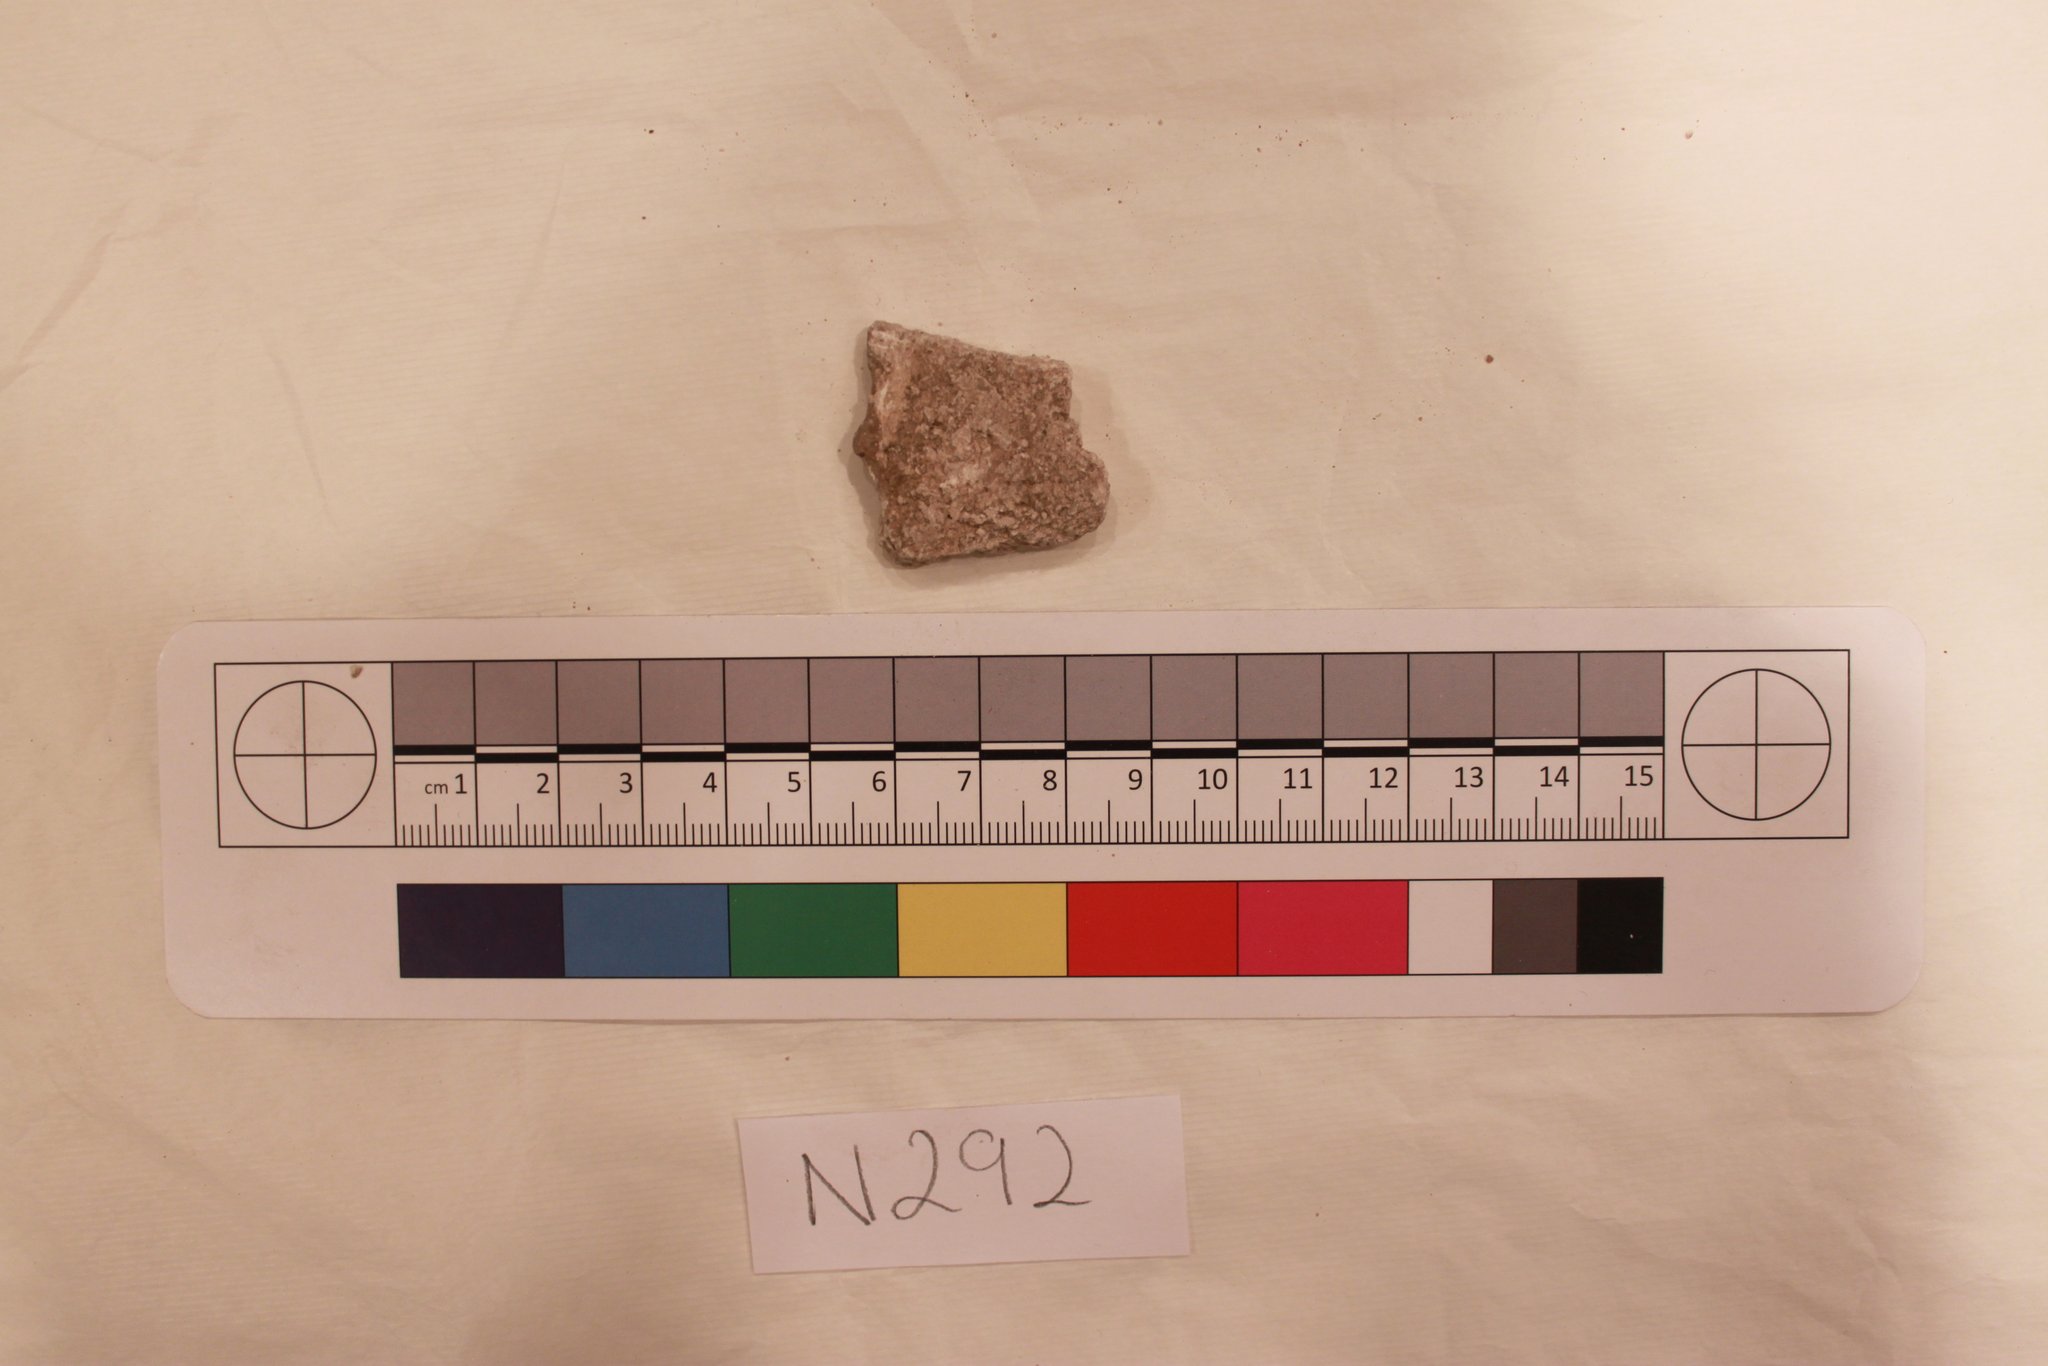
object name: fragment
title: Stucco Fragment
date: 701-1200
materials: plaster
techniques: carving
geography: iran